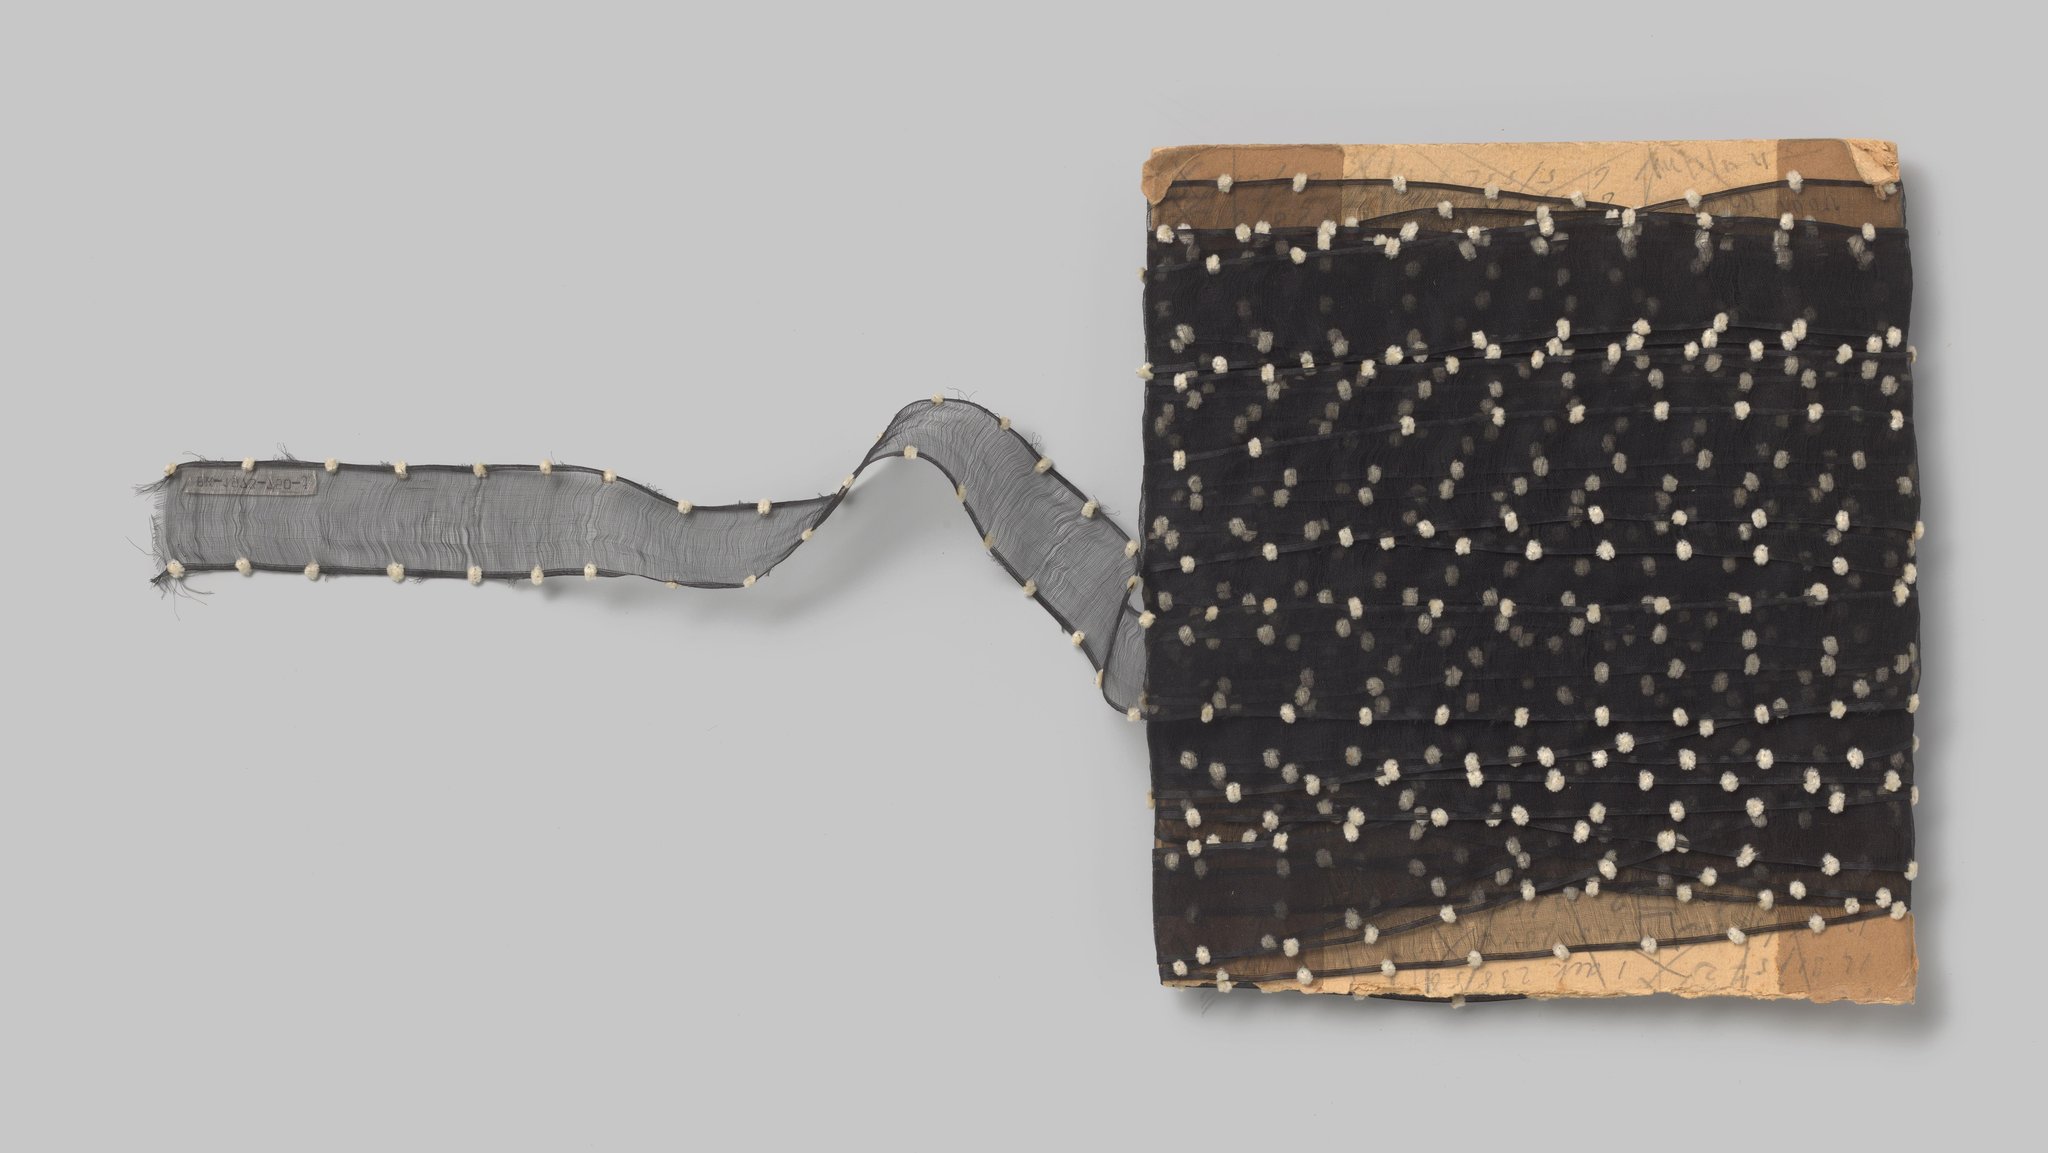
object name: braid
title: Karton waarop zwart lint van zijden gaas, met aan beide randen iedere twee cm een witte fluwelen bol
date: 1900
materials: silk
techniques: weave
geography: france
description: Karton waarop zwart lint van zijden gaas, met aan beide randen iedere twee cm een witte fluwelen bol.